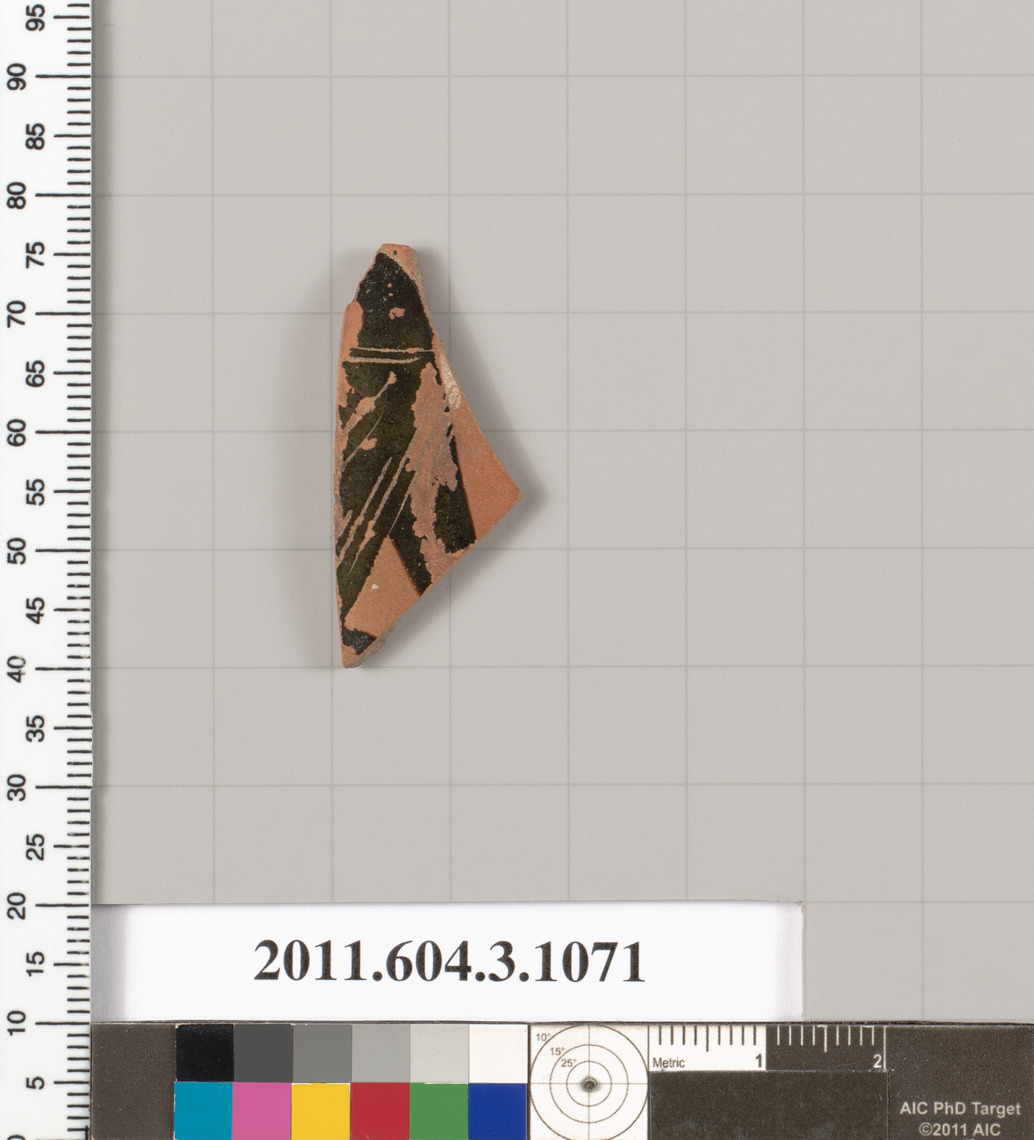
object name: mastoid fragment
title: Terracotta fragment of a mastoid (drinking cup with narrow base)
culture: greek, attic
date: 534-468 BCE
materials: terracotta